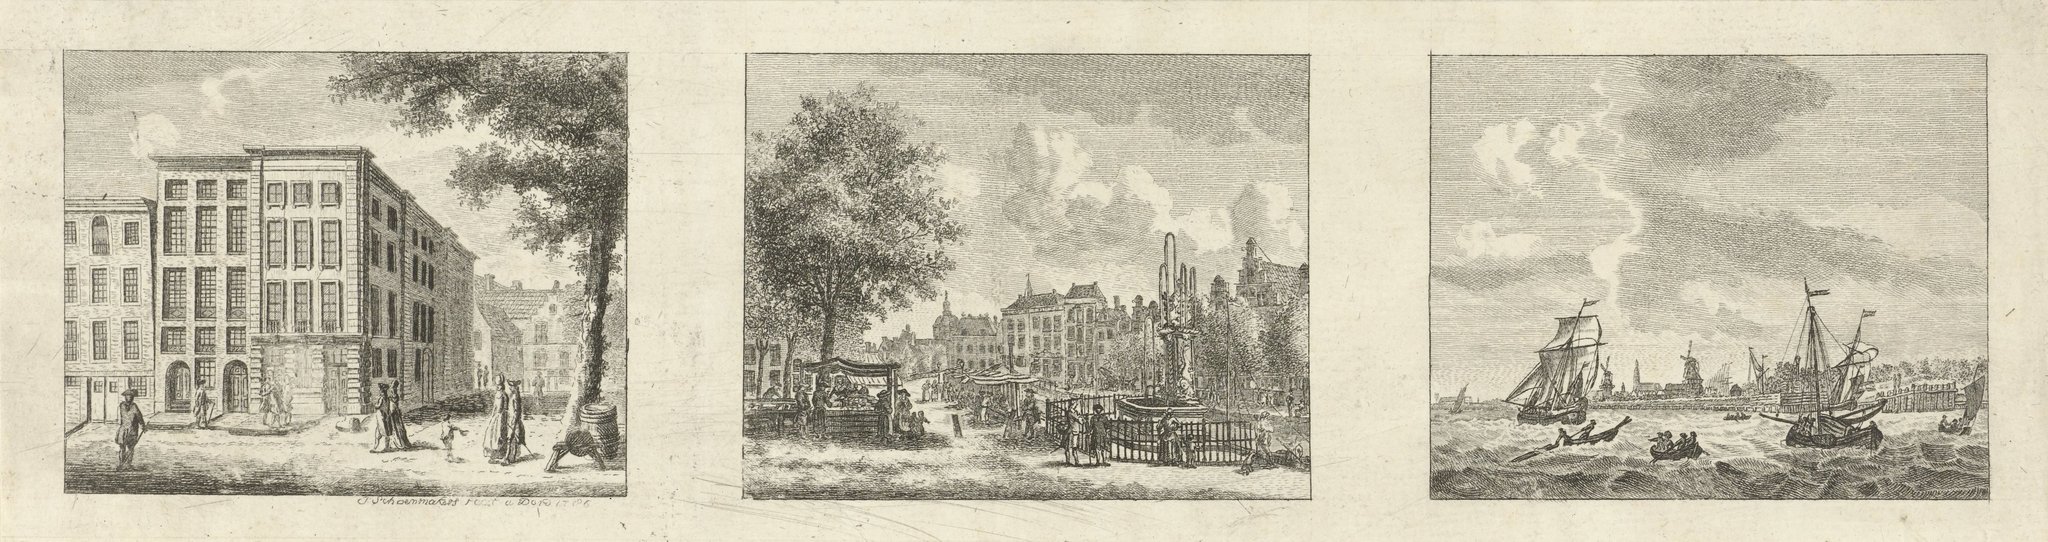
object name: print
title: Drie stadsgezichten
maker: johannes schoenmakers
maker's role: painter, print maker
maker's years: 1755-1842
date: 1786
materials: paper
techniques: engraving, etching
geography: dordrecht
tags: prospect of city, town panorama, silhouette of city - ii - ideal city, sailing-ship, sailing-boat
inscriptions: collector's mark: Lugt 2166, collector's mark: Lugt 2760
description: Drie stadsgezichten op een blad. Links en midden gezichten in een stad. Rechts een gezicht over het water op een stad.